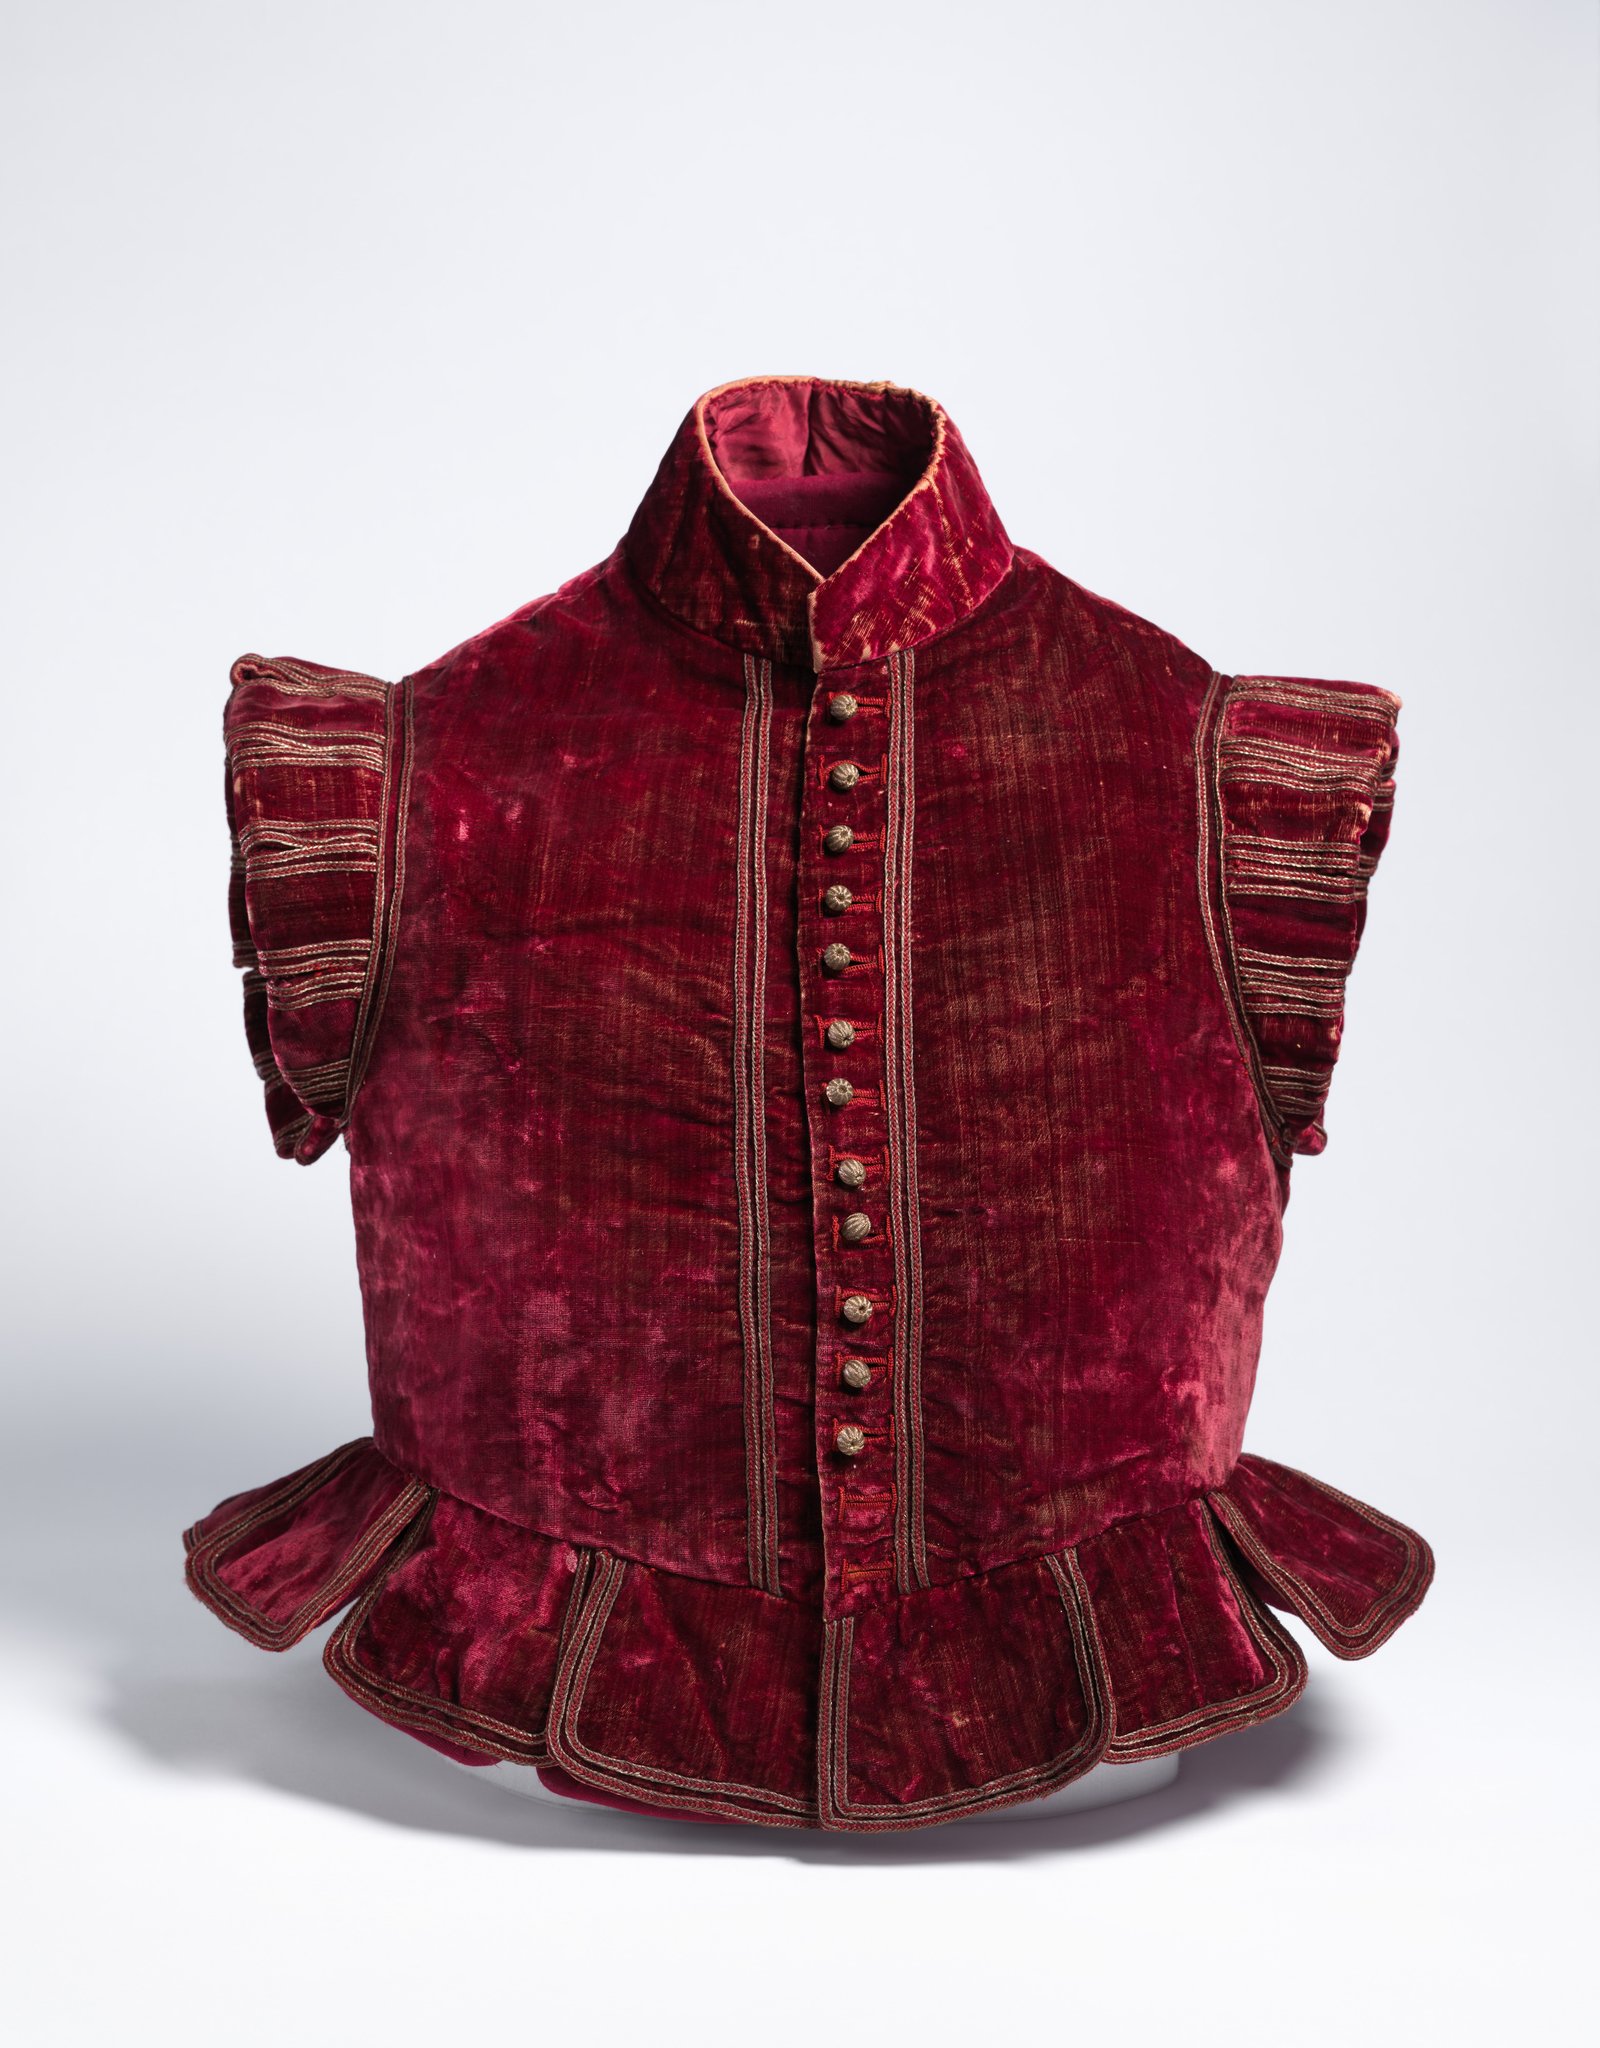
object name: jerkin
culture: british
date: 1610-1625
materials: cotton, linen, metal, silk